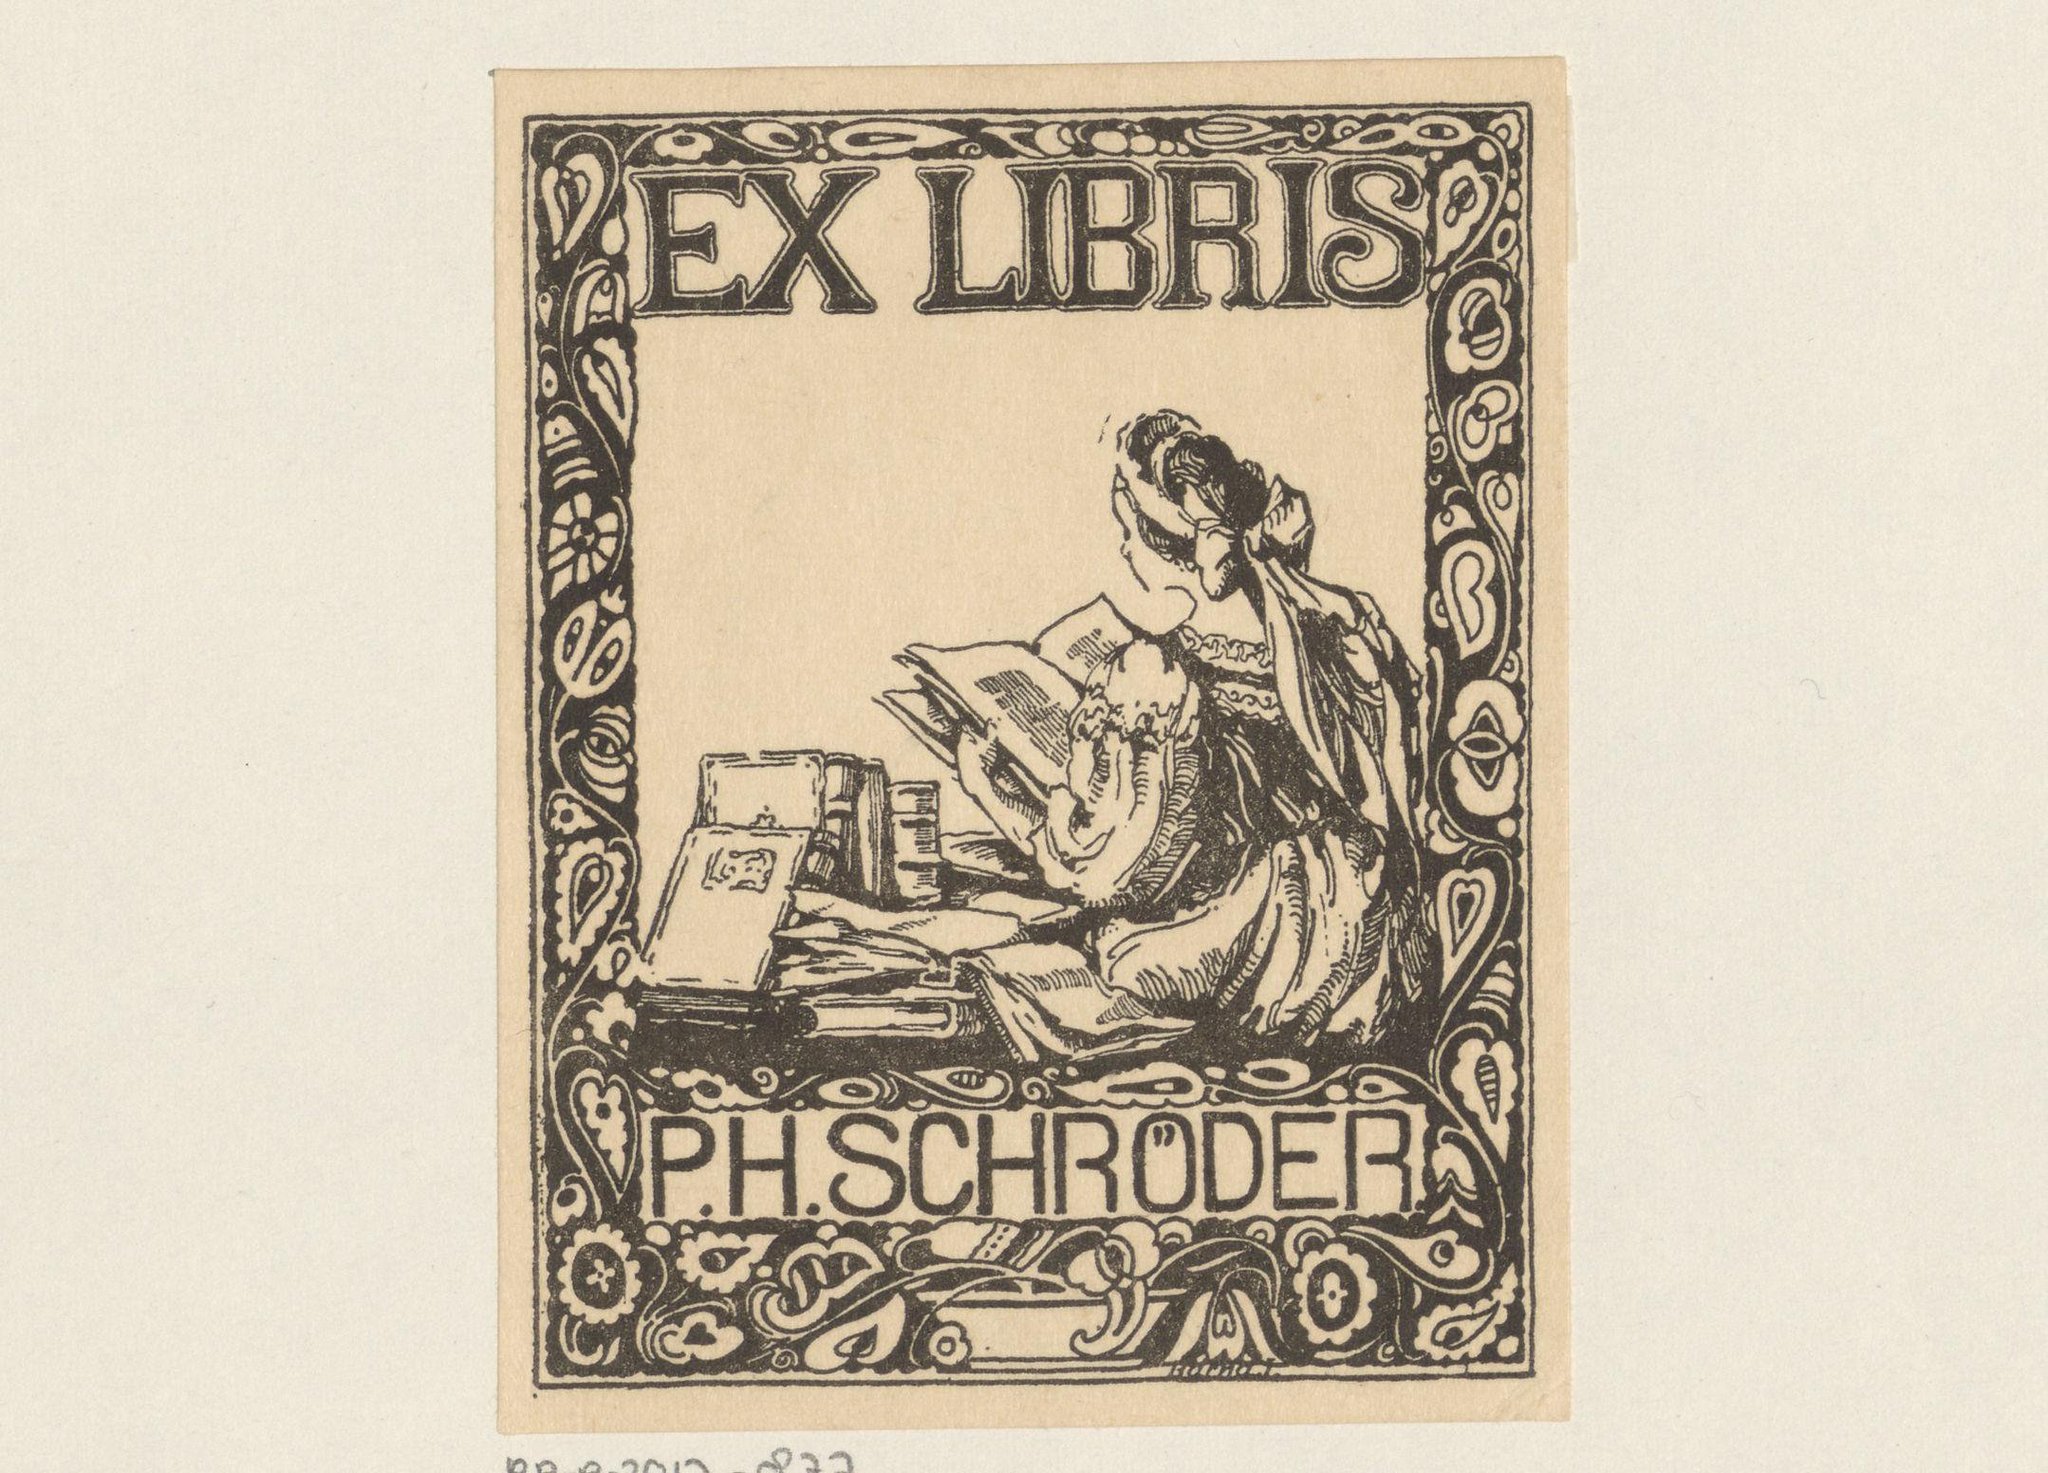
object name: bookplate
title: Ex libris van P.H. Schröder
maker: j. bacha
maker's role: print maker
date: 1850-1950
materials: paper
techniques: lithograph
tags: adult woman, reading, book